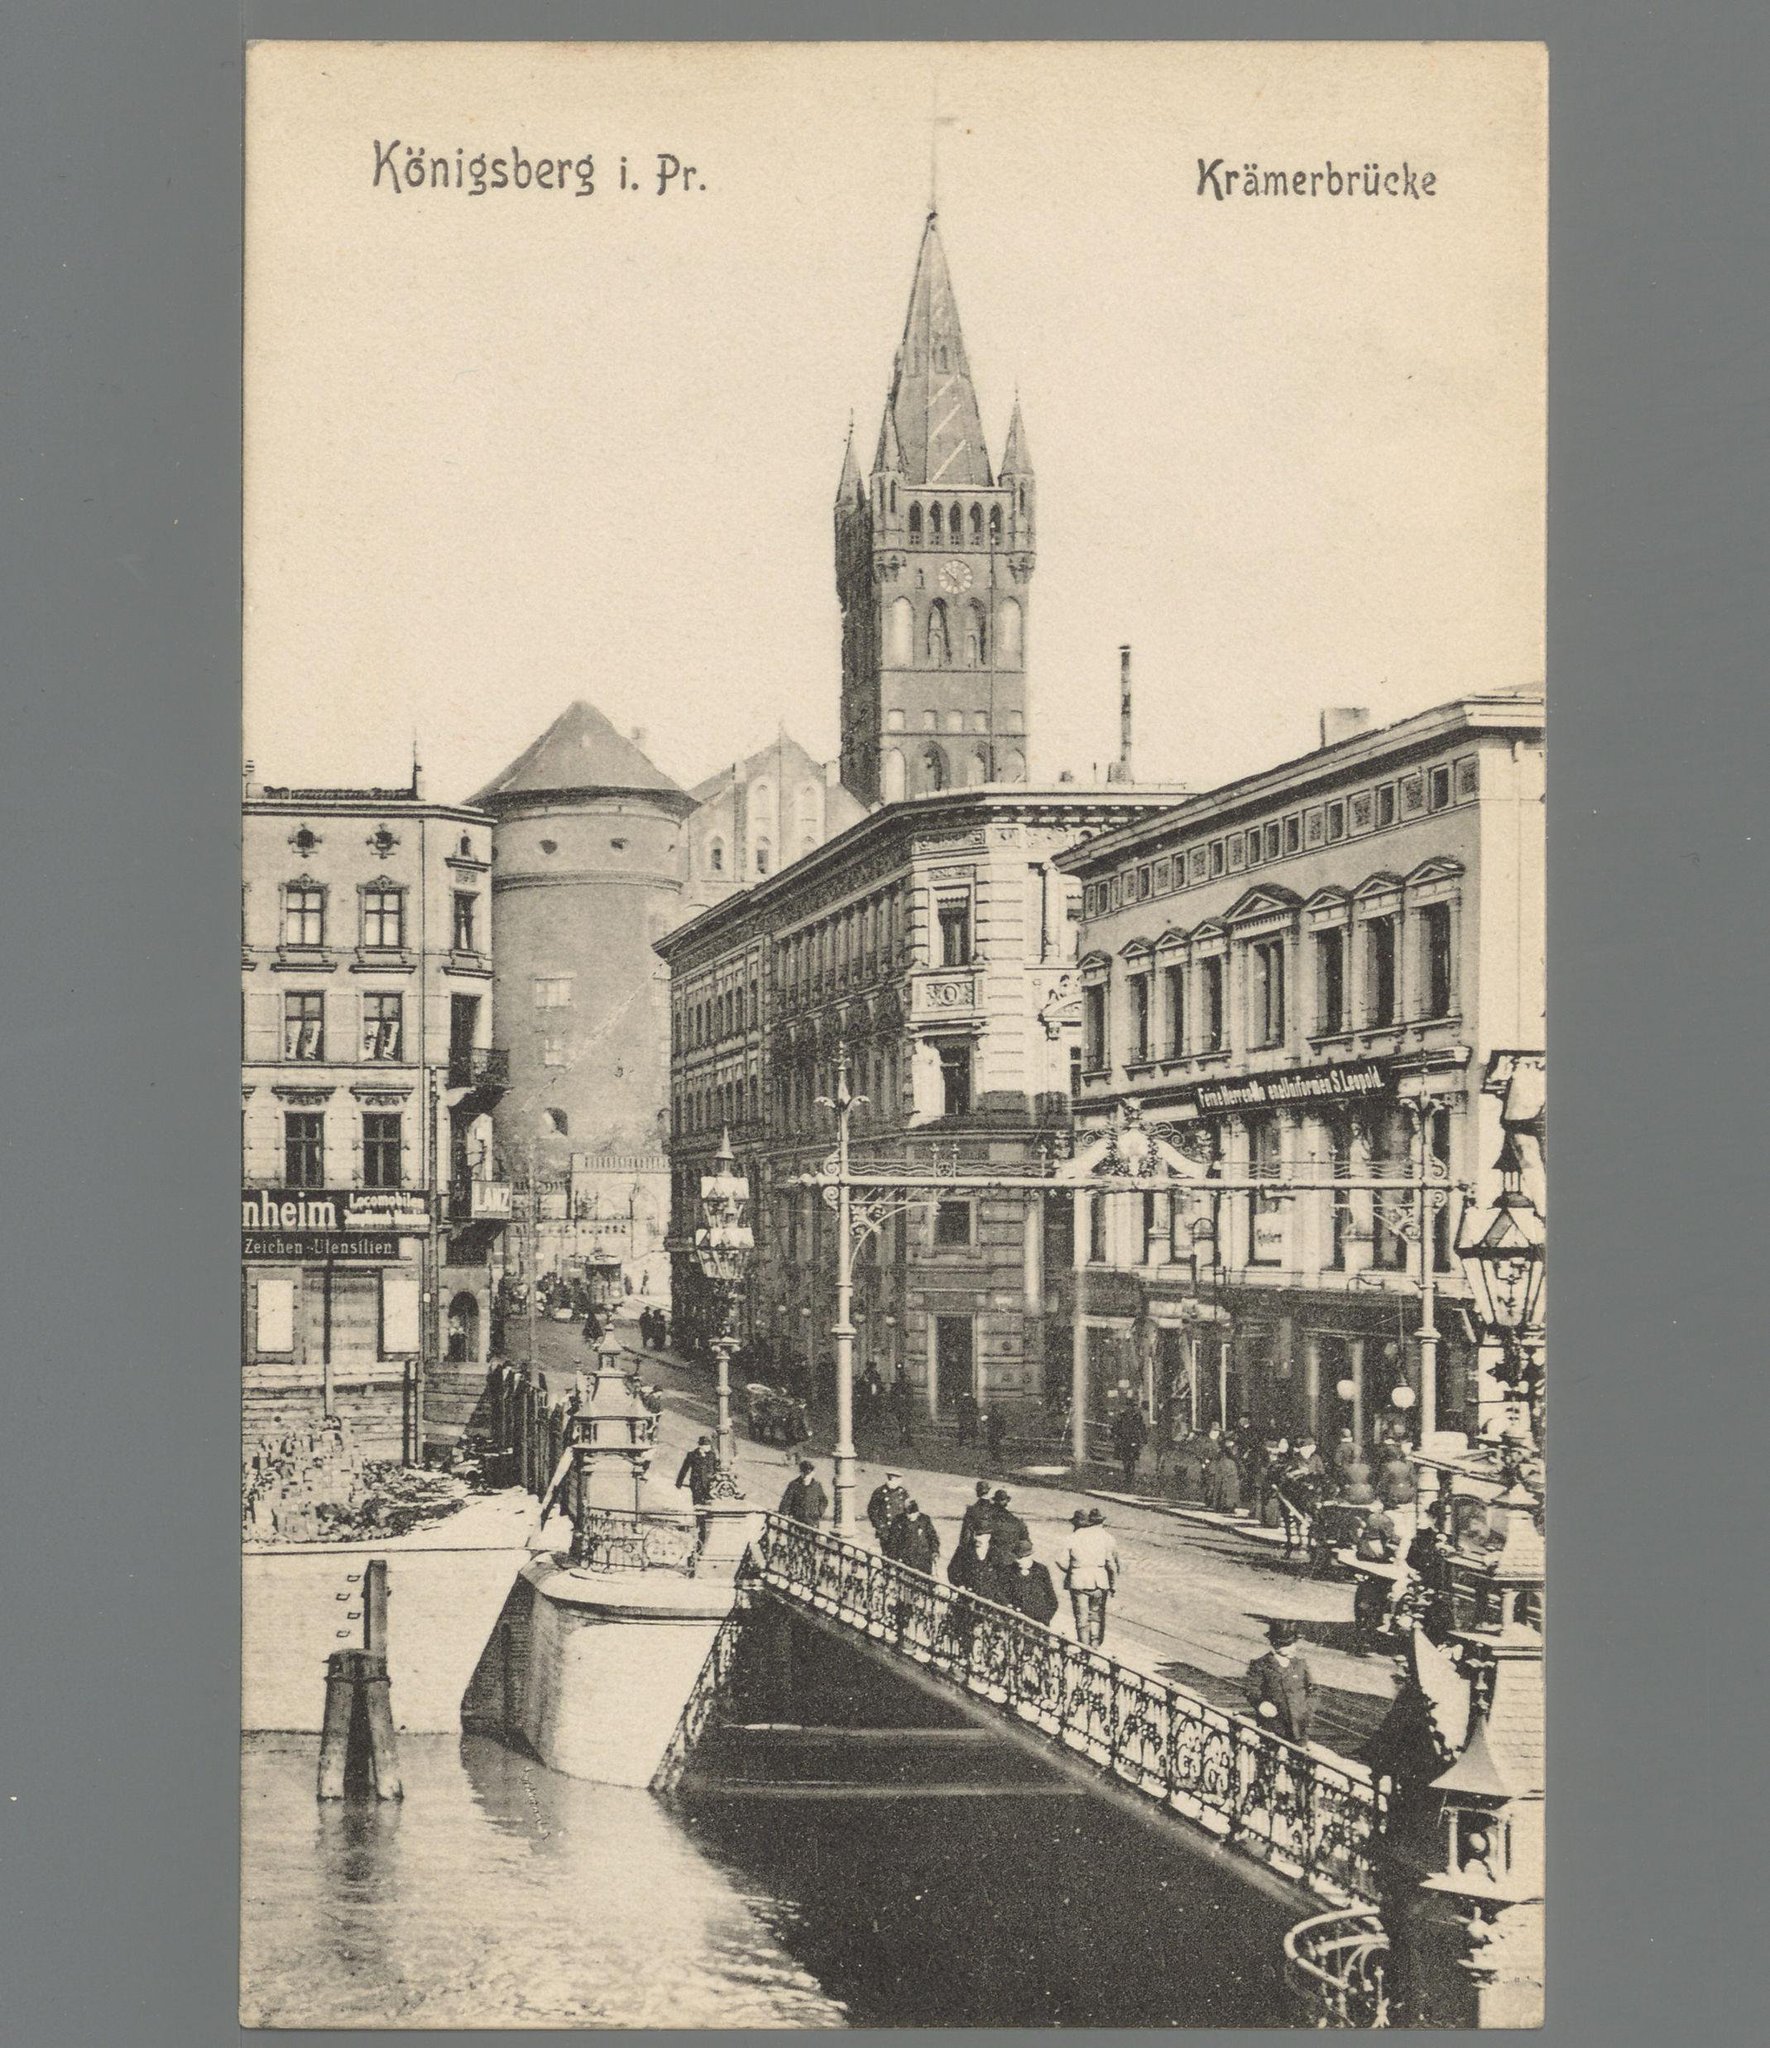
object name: photomechanical print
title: Königsberg i. Pr. Krämerbrücke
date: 1905-1930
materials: cardboard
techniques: photograph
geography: königsberg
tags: church (exterior), bridge in city across river, canal, etc., street